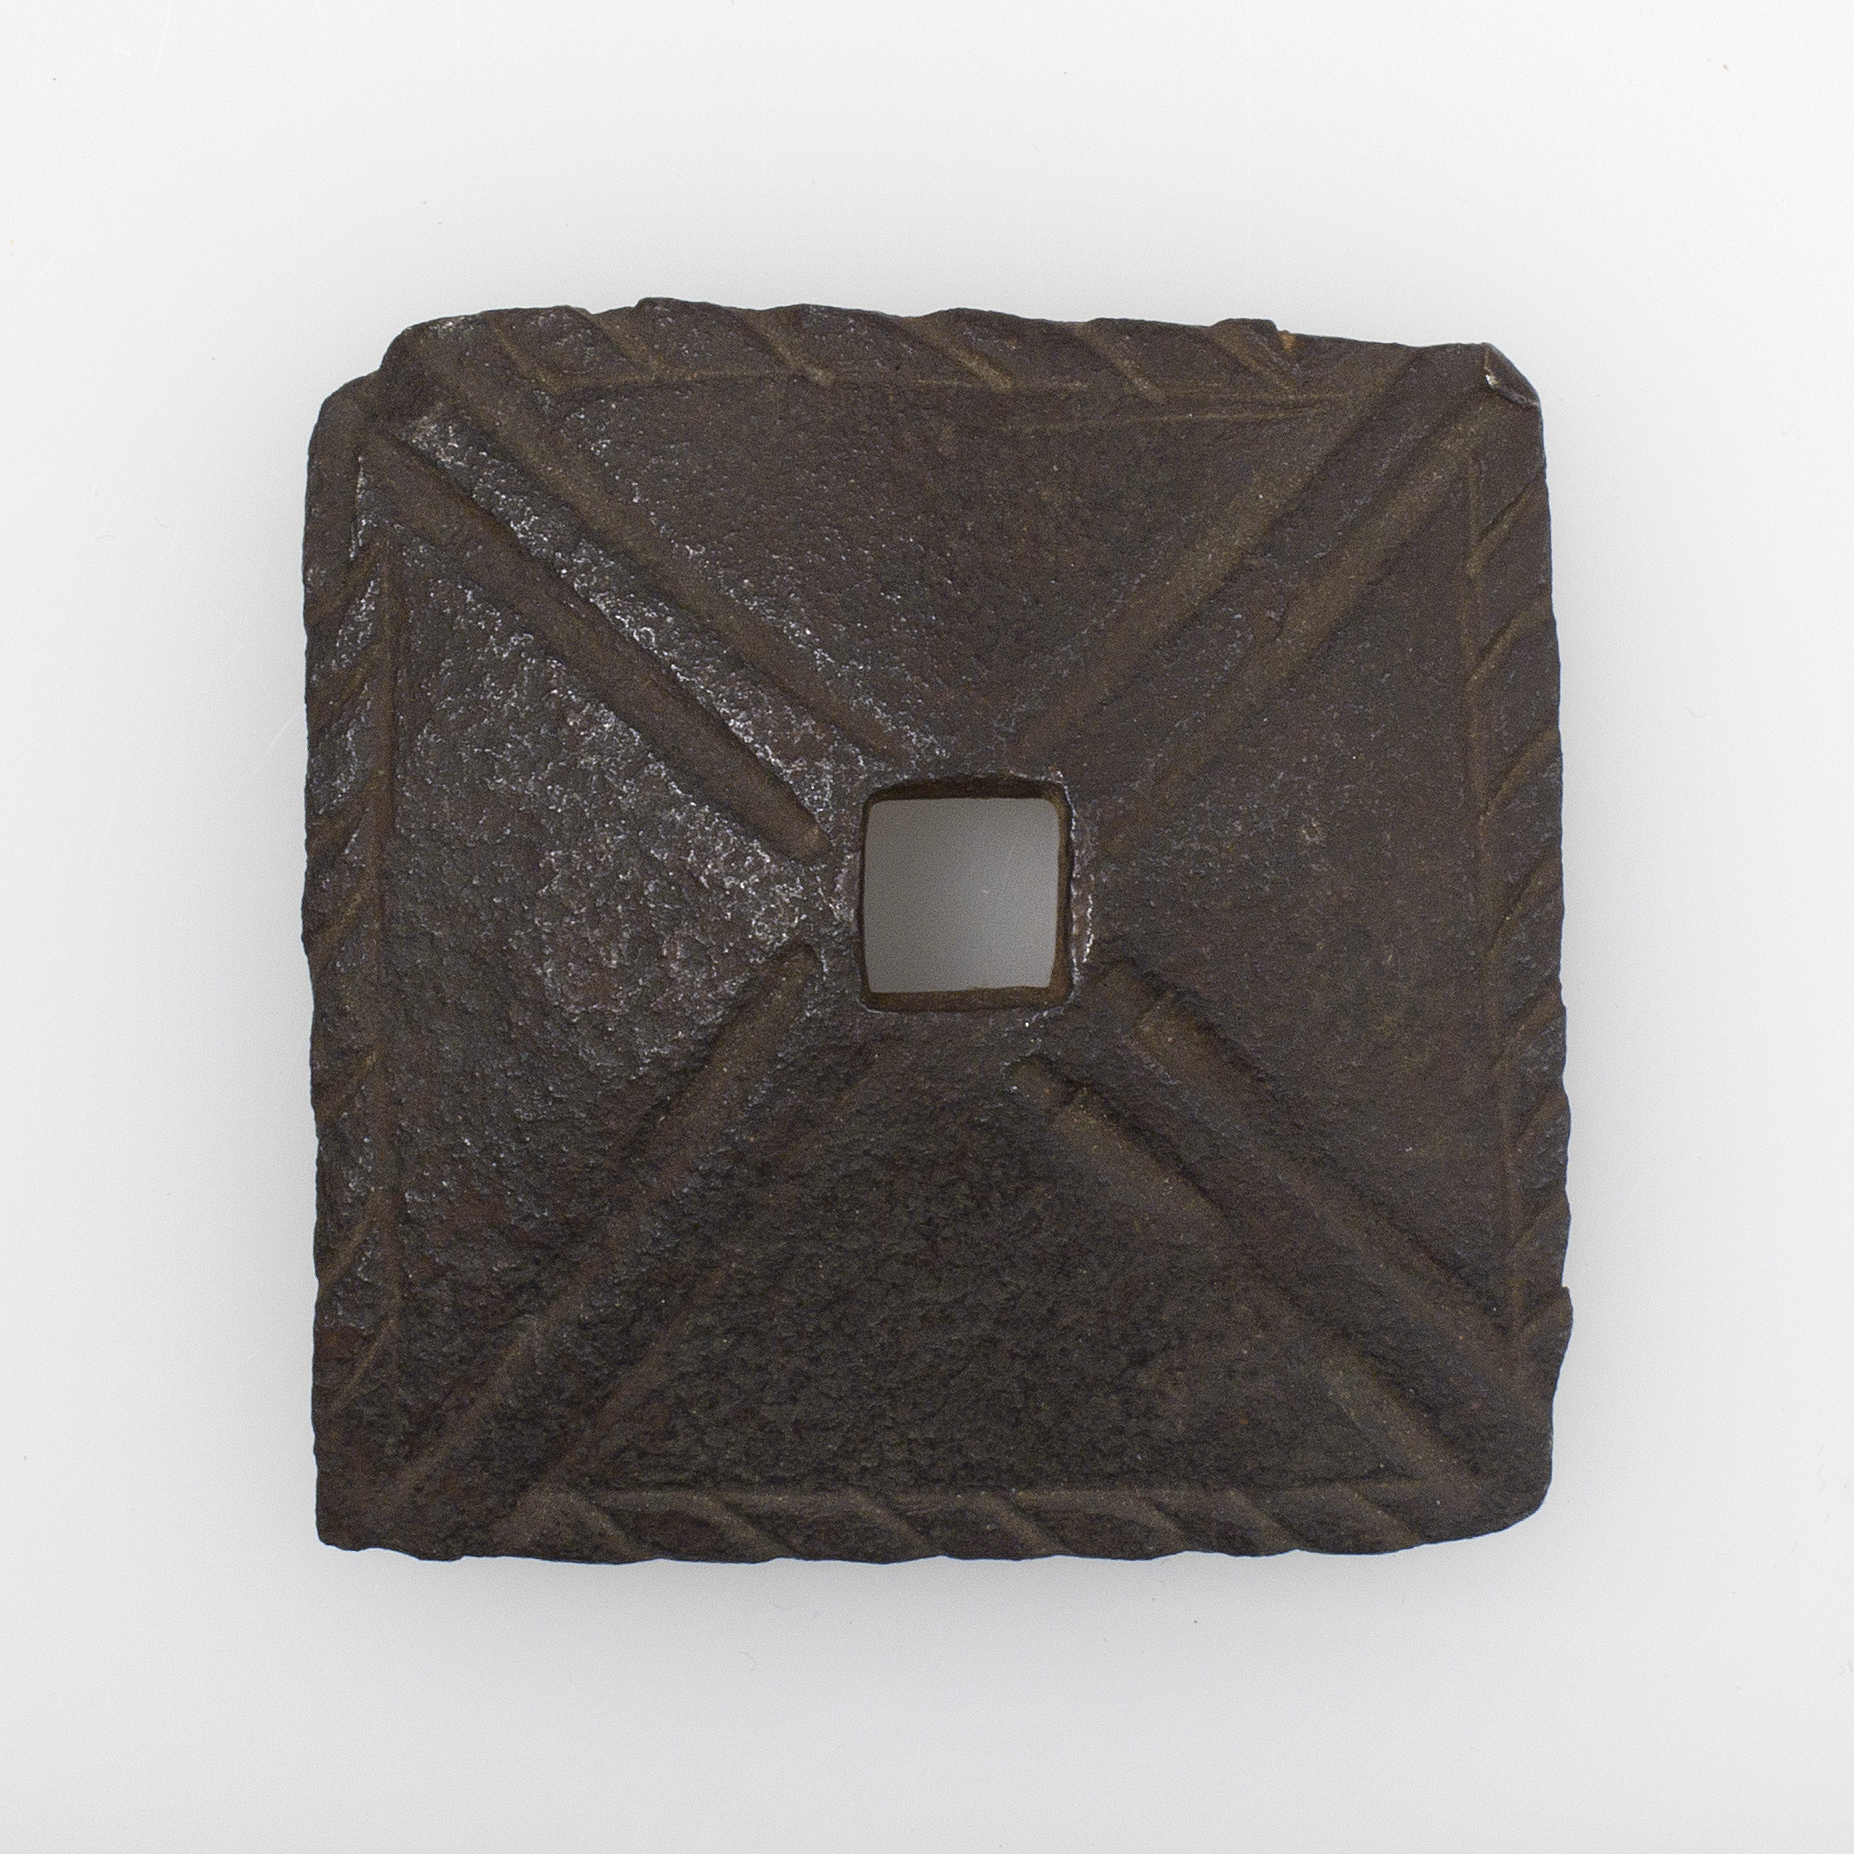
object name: plate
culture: european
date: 1401-1600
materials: iron